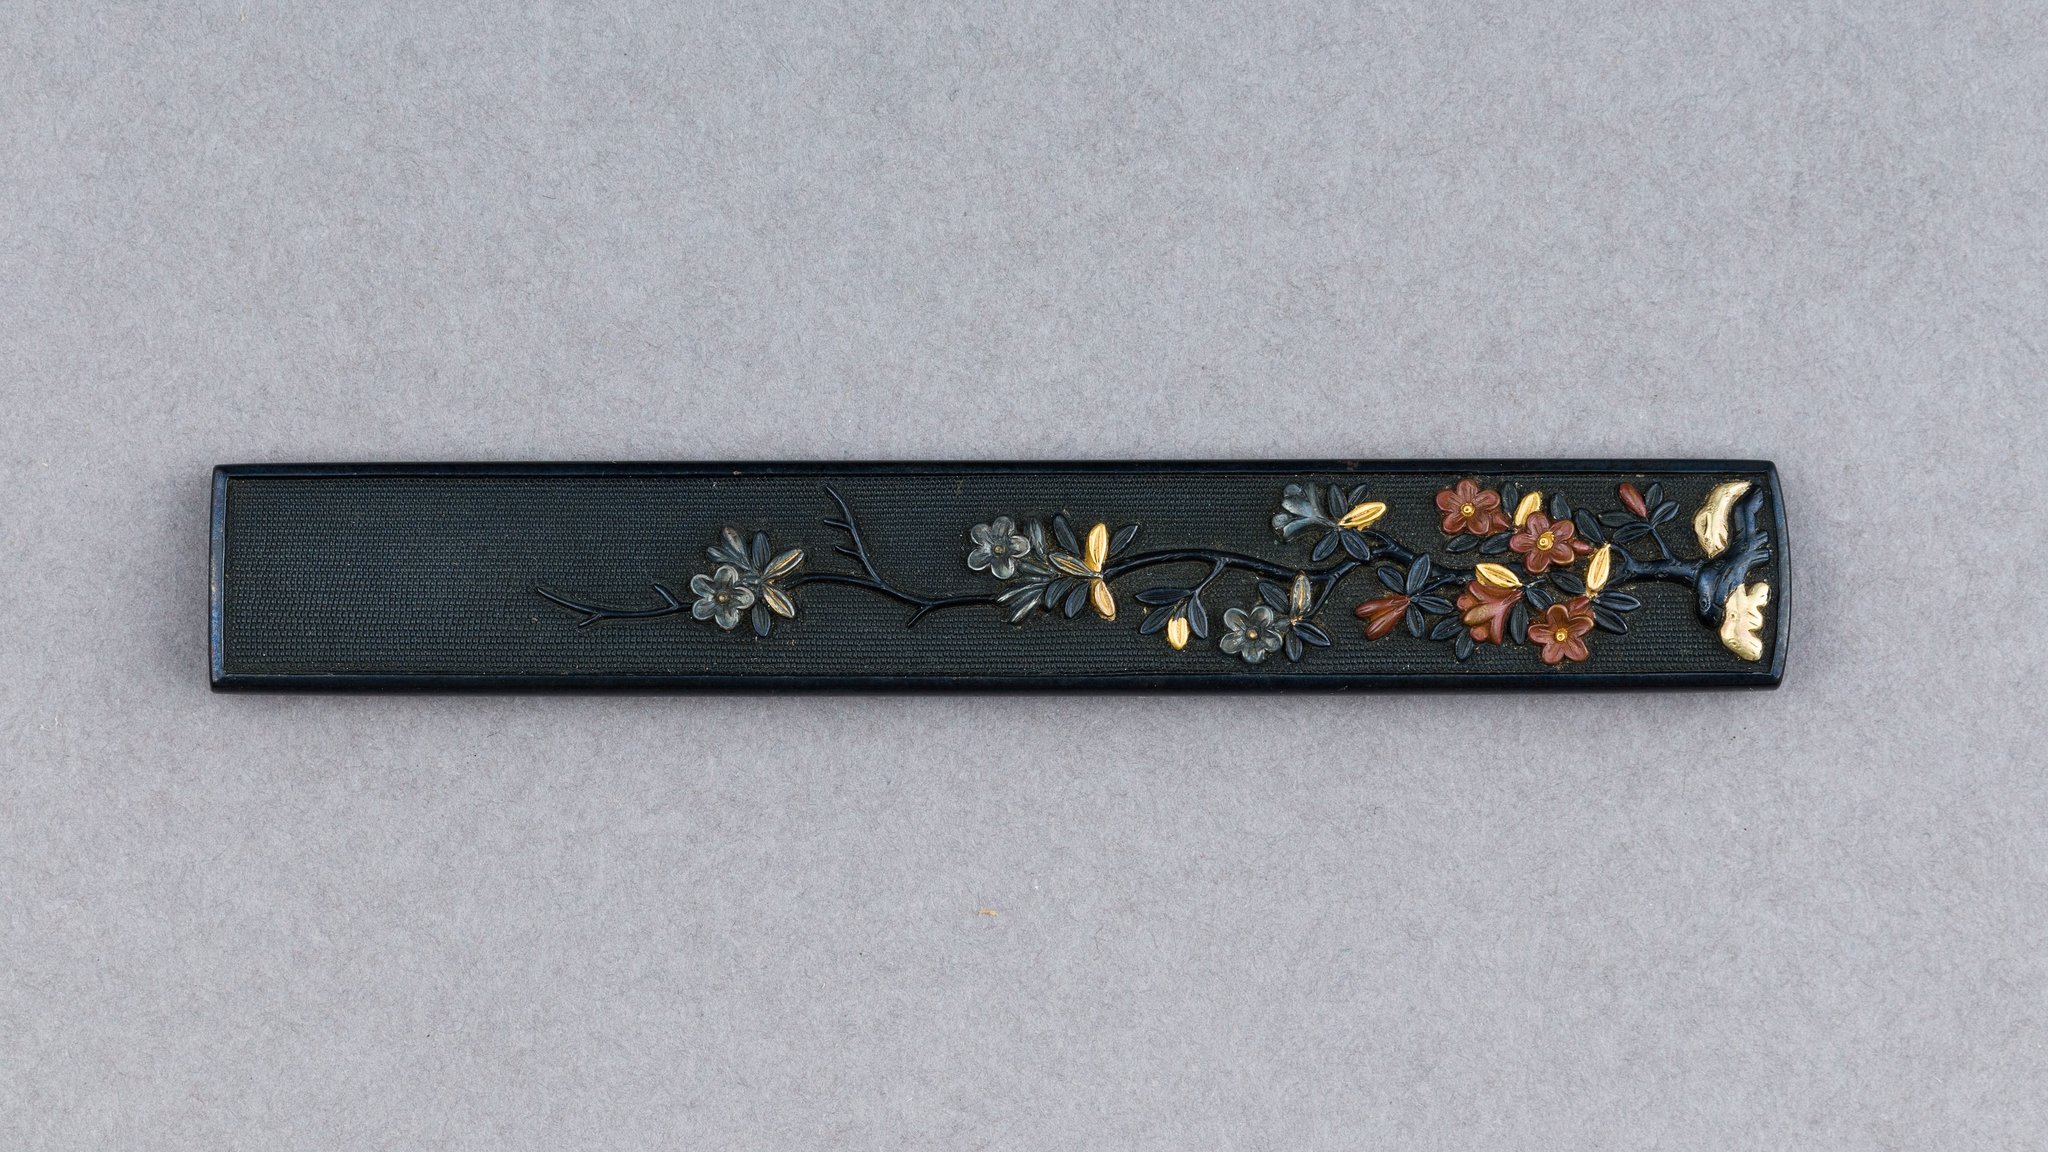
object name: knife handle kozuka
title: Knife Handle (Kozuka)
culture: japanese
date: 1615-1868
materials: copper, gold alloy, silver alloy, gold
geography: japan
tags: flowers